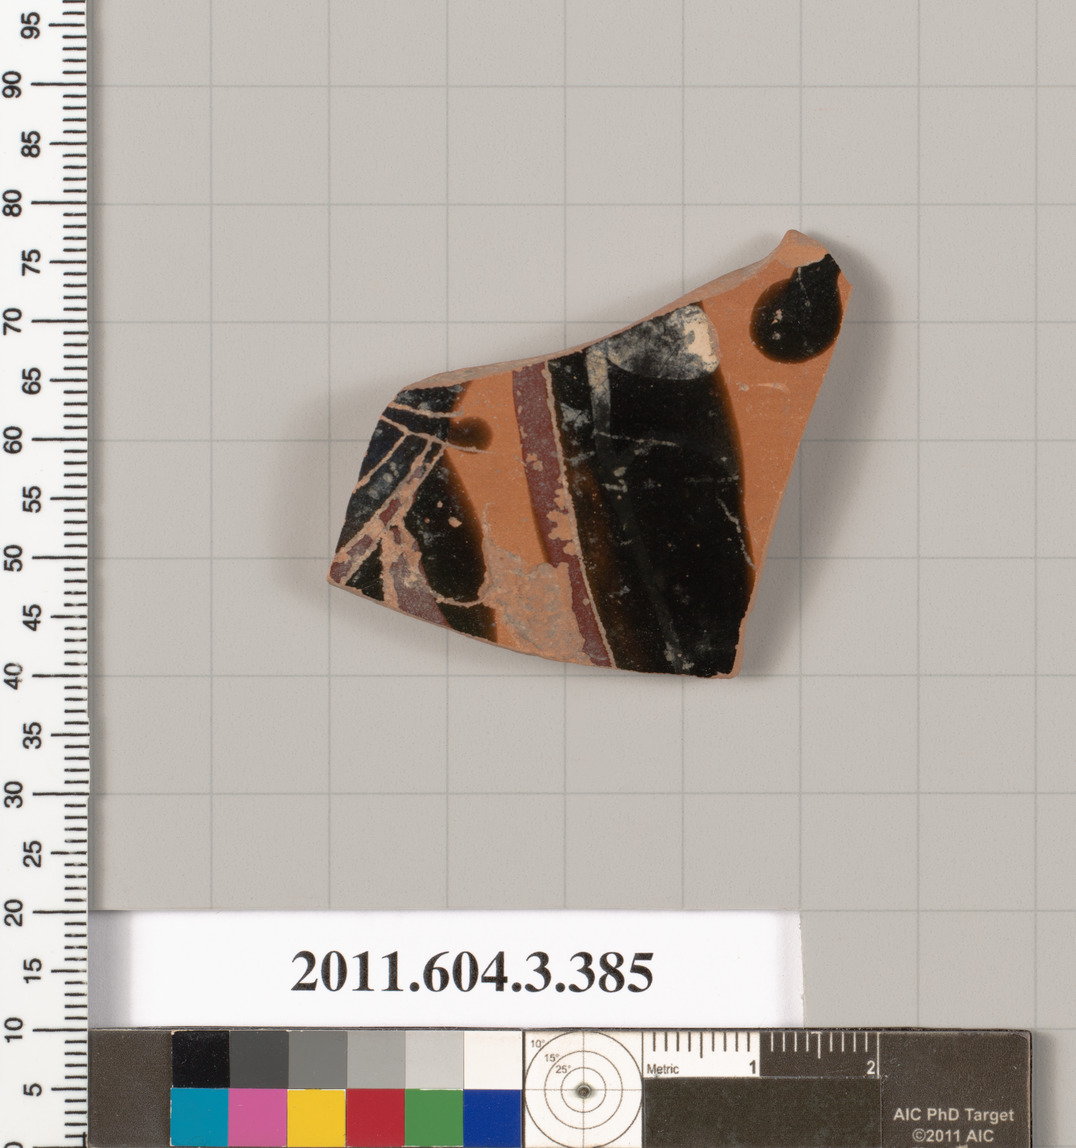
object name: neck amphora fragment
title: Terracotta fragment of a neck-amphora (jar)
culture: greek, attic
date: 520-510 BCE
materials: terracotta